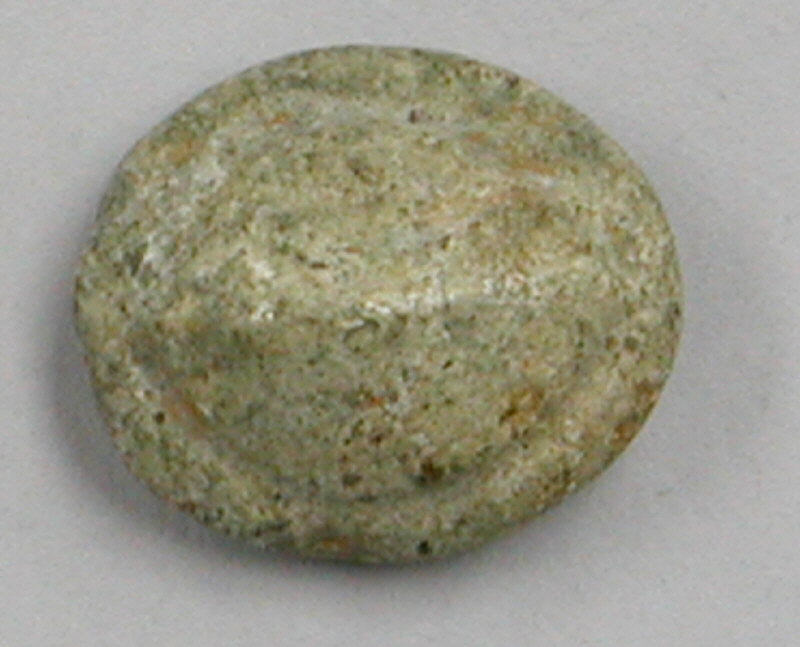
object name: pendant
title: Stone Turtle Pendant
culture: mexican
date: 1501-1600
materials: stone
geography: mexico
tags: turtles